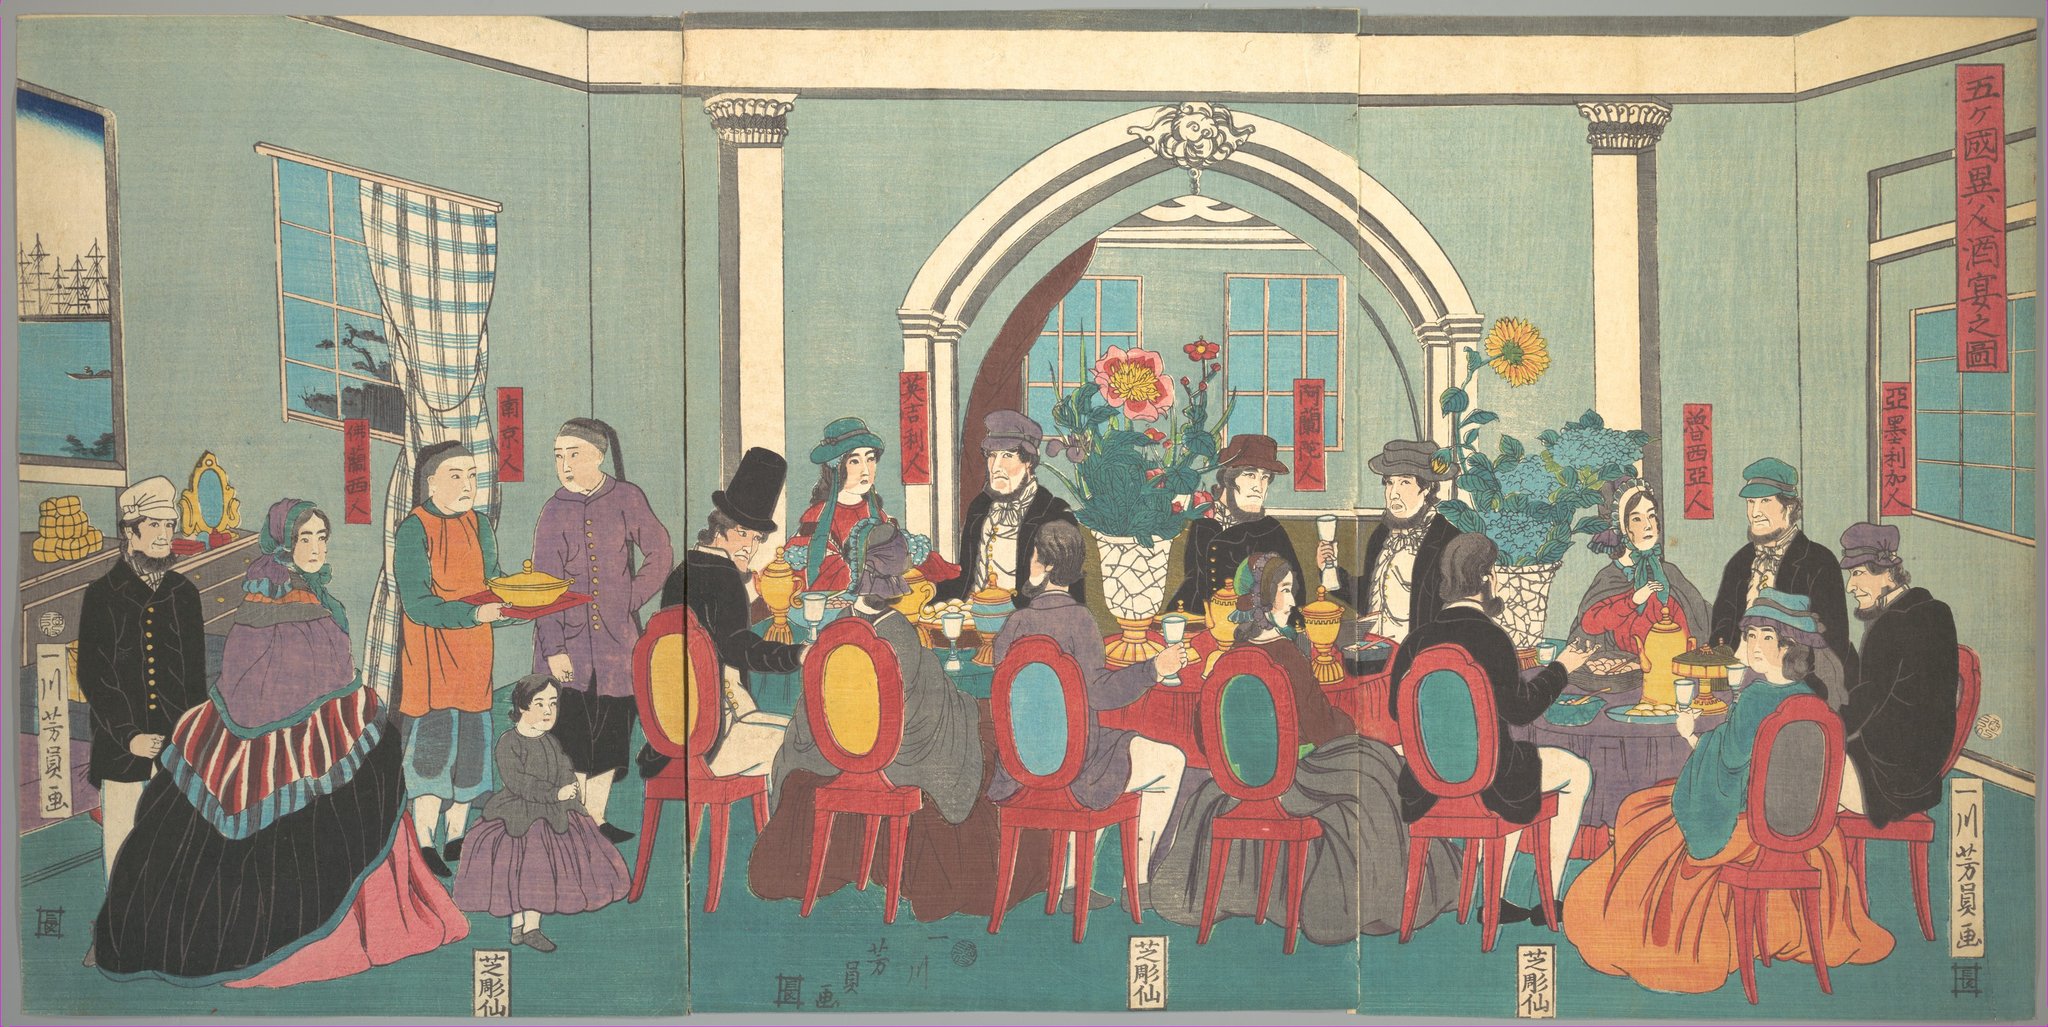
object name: print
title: Foreigners from the Five Nations Enjoying a Banquet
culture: japanese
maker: utagawa yoshikazu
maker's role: artist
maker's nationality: japanese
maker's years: 1845-1870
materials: ink, paper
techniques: woodblock print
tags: men,women,party,flowers,chairs